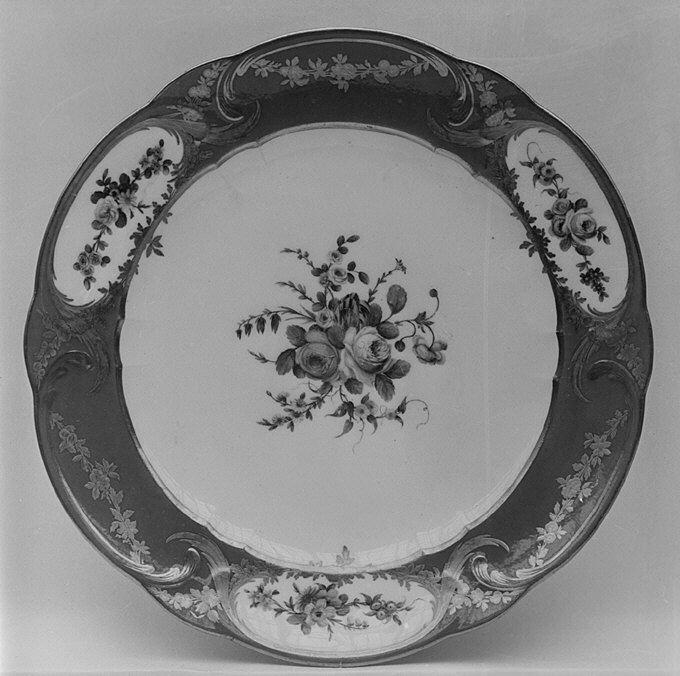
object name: plate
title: Plate (assiette à palmes) (1 of 102) (part of a service)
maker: sèvres manufactory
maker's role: manufactory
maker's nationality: french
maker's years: 1740-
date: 1780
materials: soft paste porcelain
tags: flowers